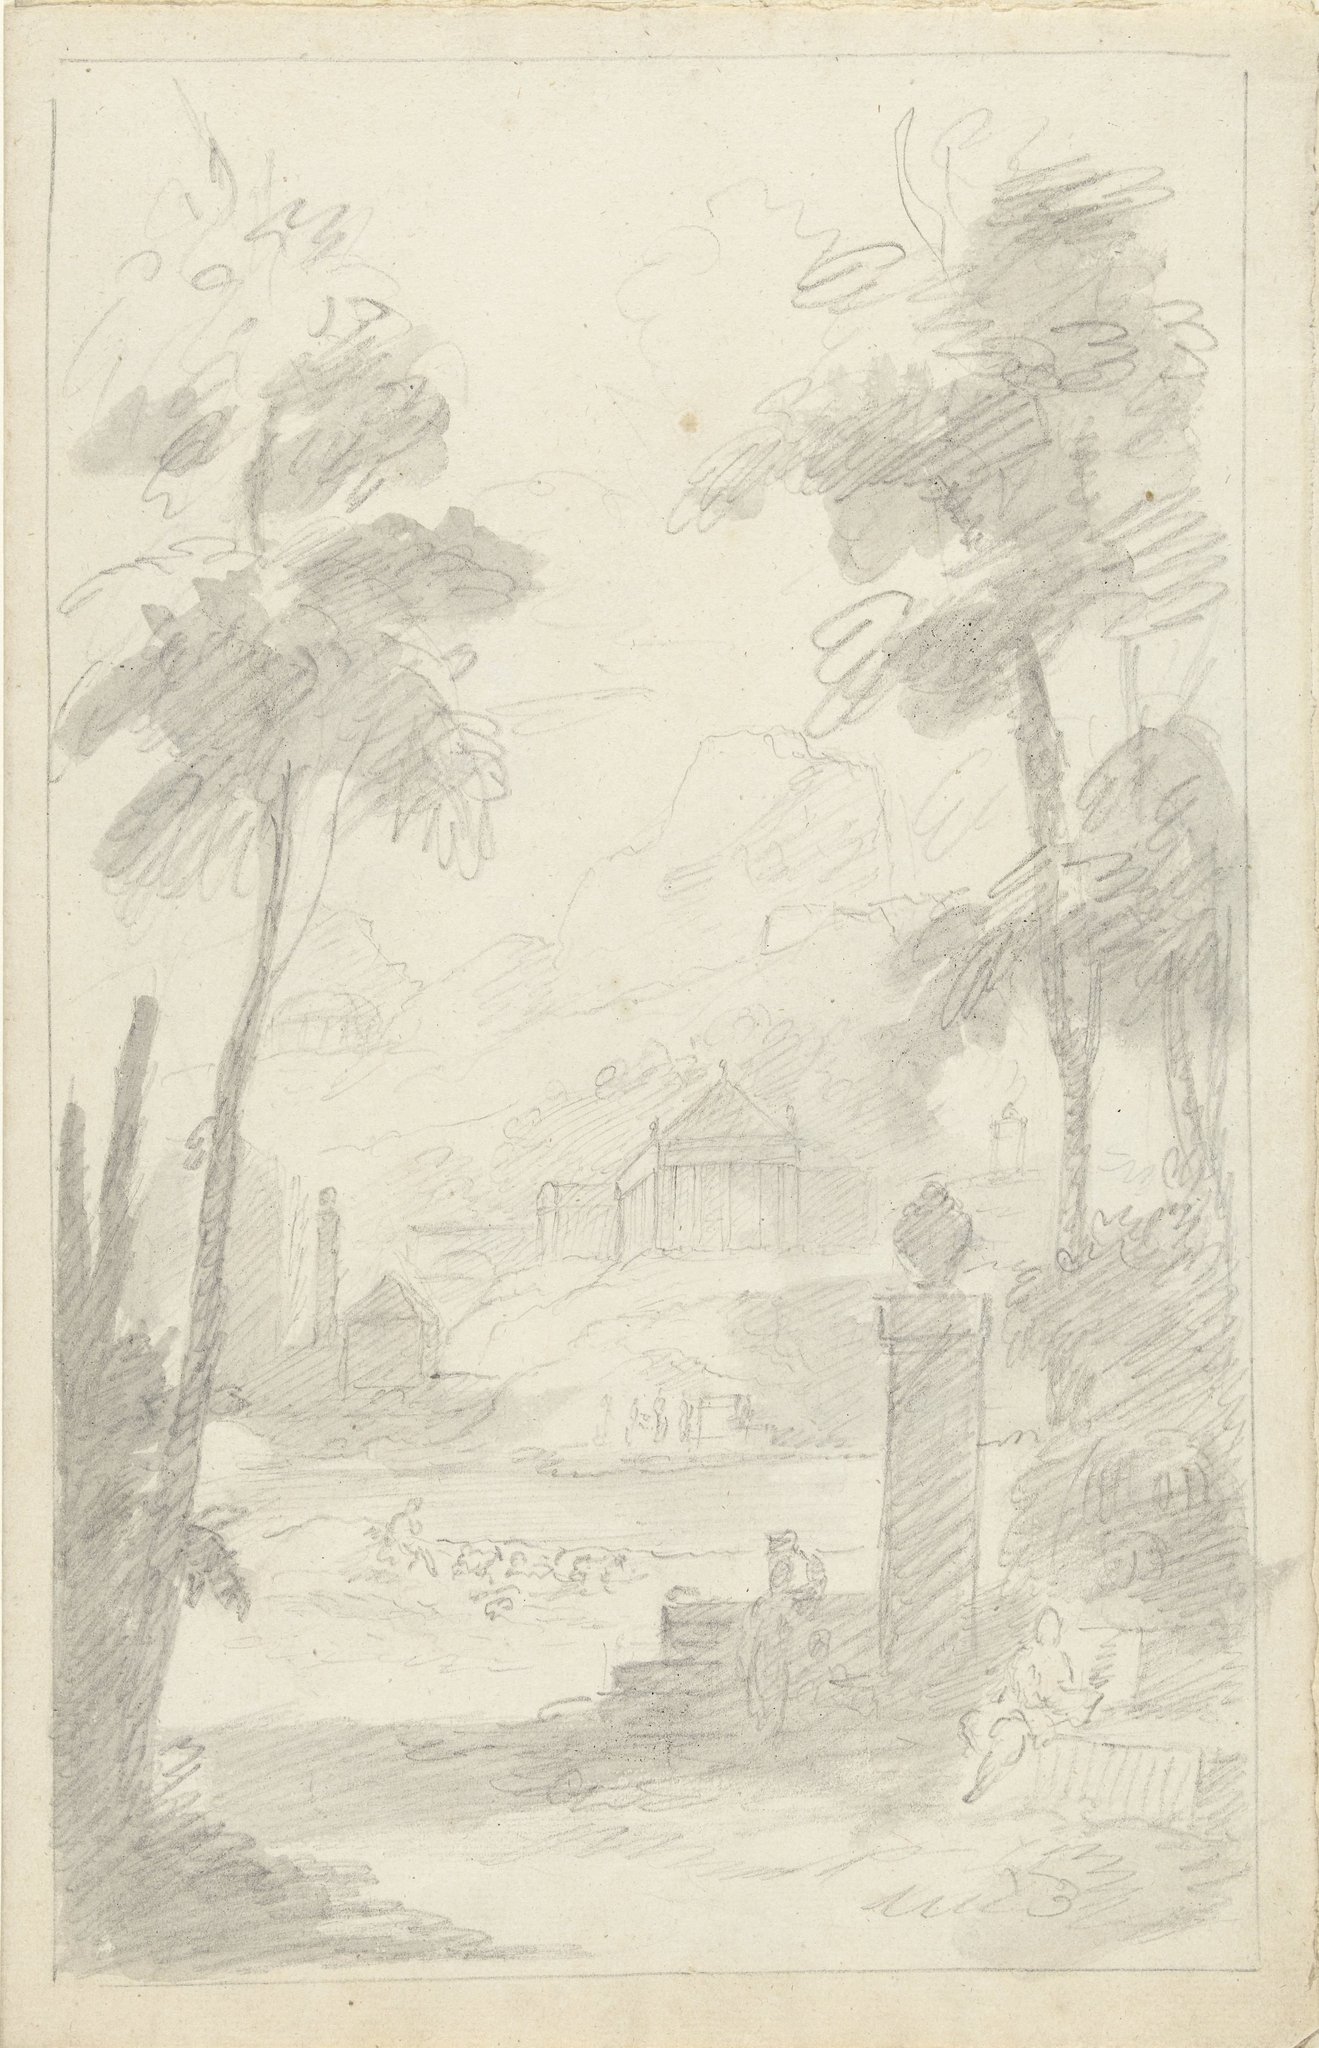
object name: design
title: Arcadisch landschap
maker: dionys van nijmegen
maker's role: draughtsman, painter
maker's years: 1705-1798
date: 1715-1798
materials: paper, pencil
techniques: brush